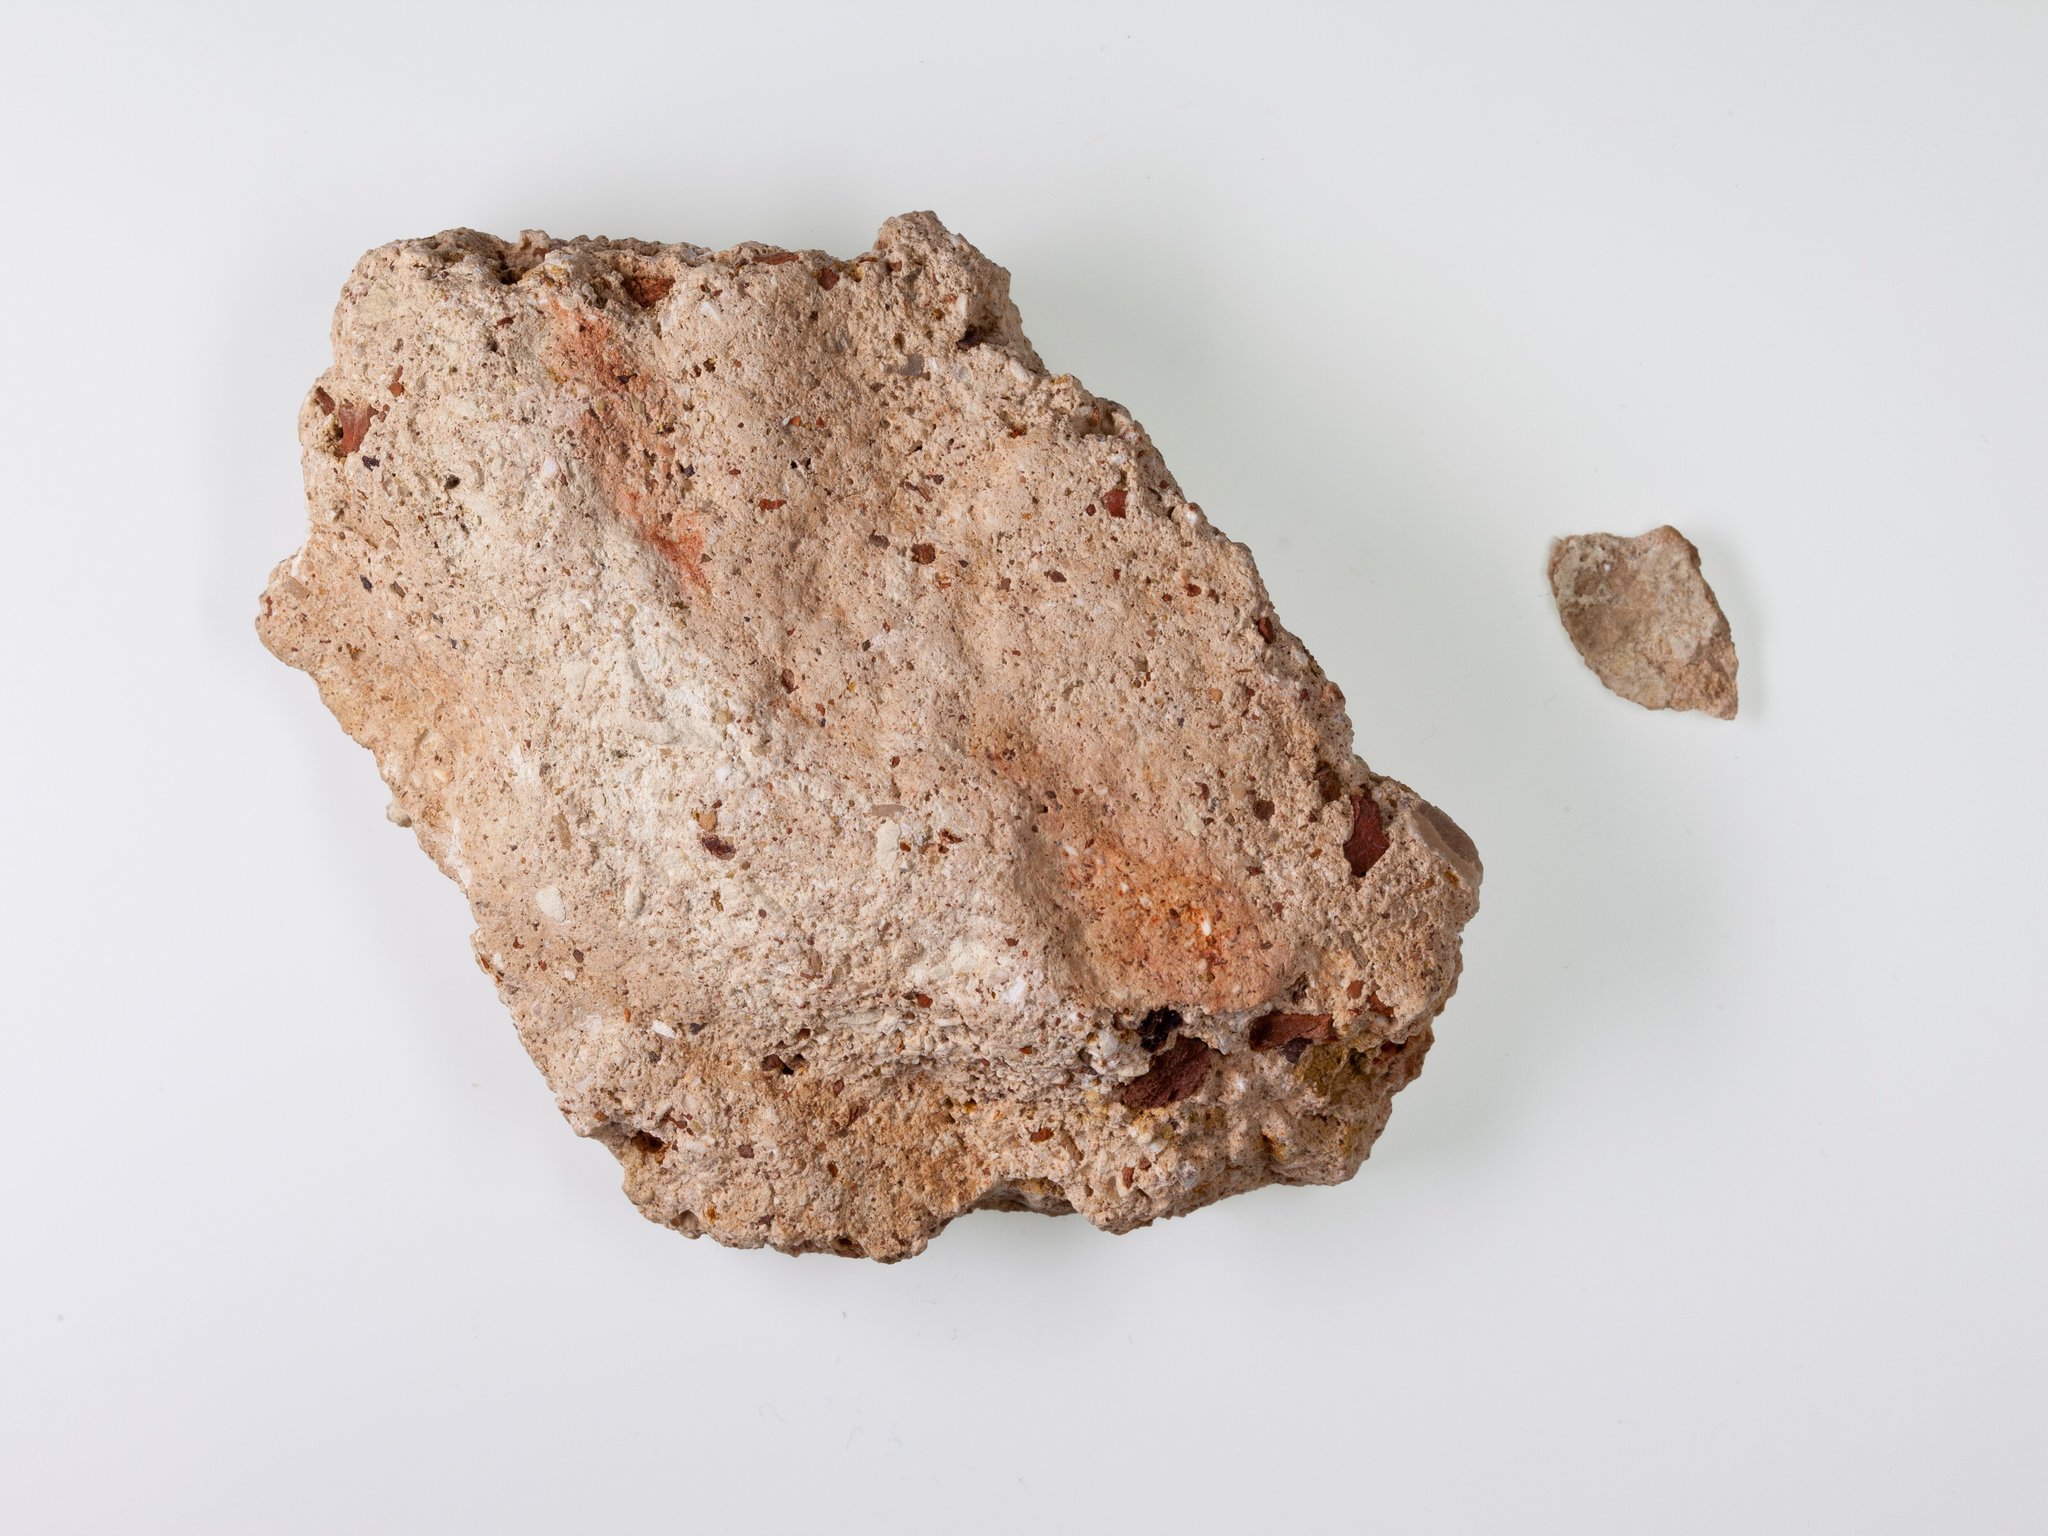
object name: mortar, giza pyramid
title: Speciman of Mortar from the Great Pyramid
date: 2550 BCE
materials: mortar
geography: egypt